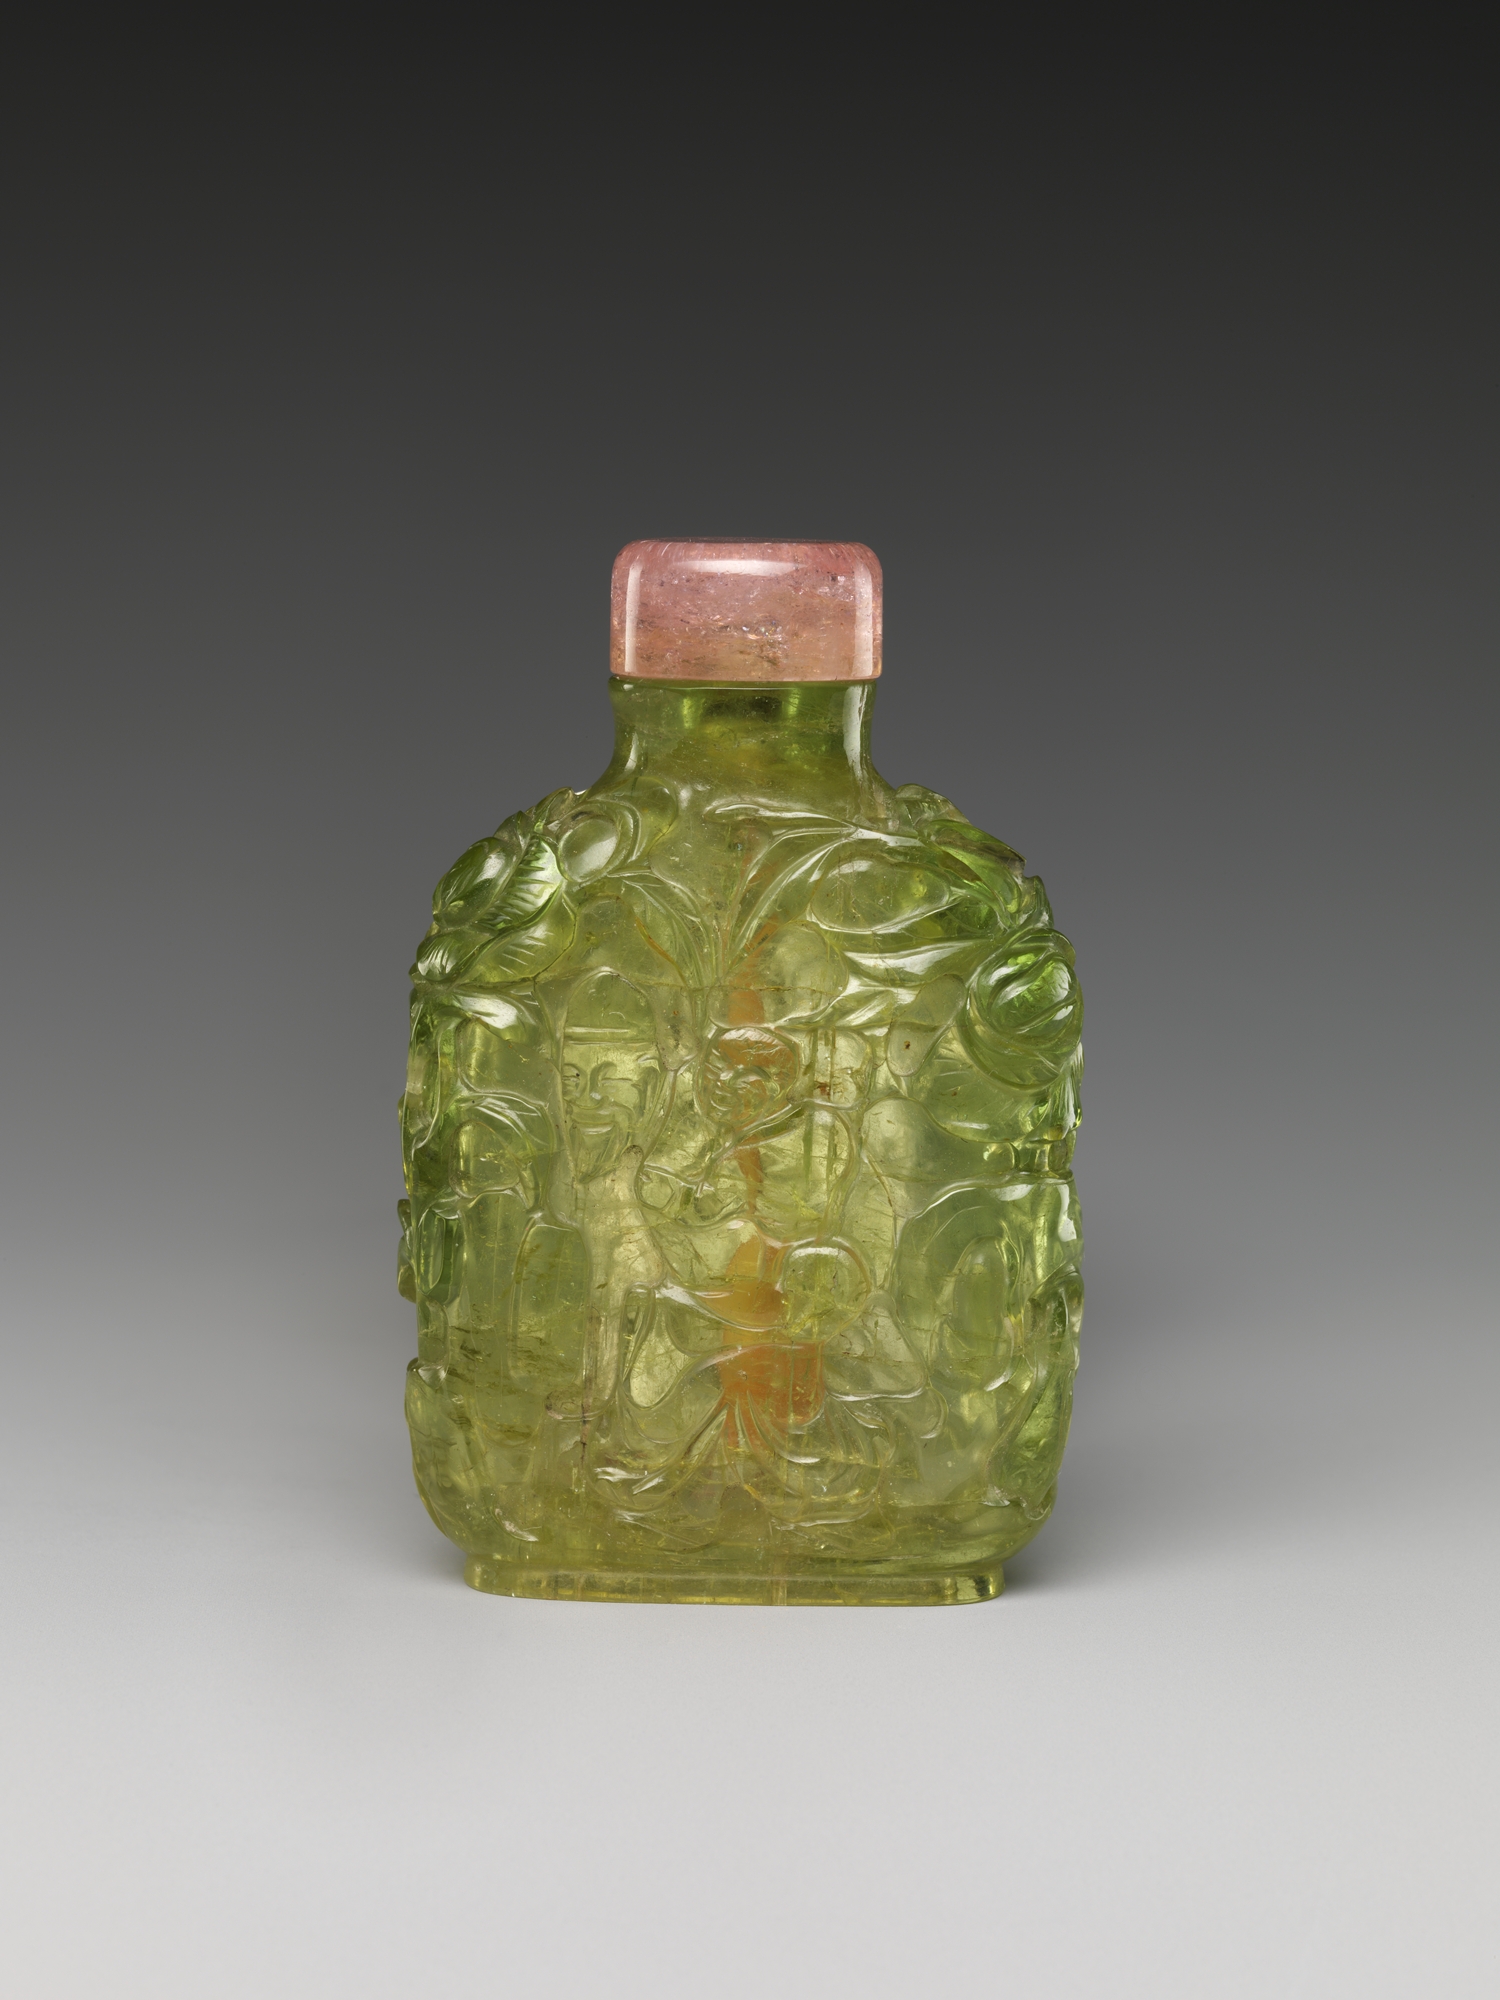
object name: snuff bottle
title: Snuff Bottle with Old Man Carrying a Boy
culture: chinese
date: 1767-1800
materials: gemstone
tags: boys,men